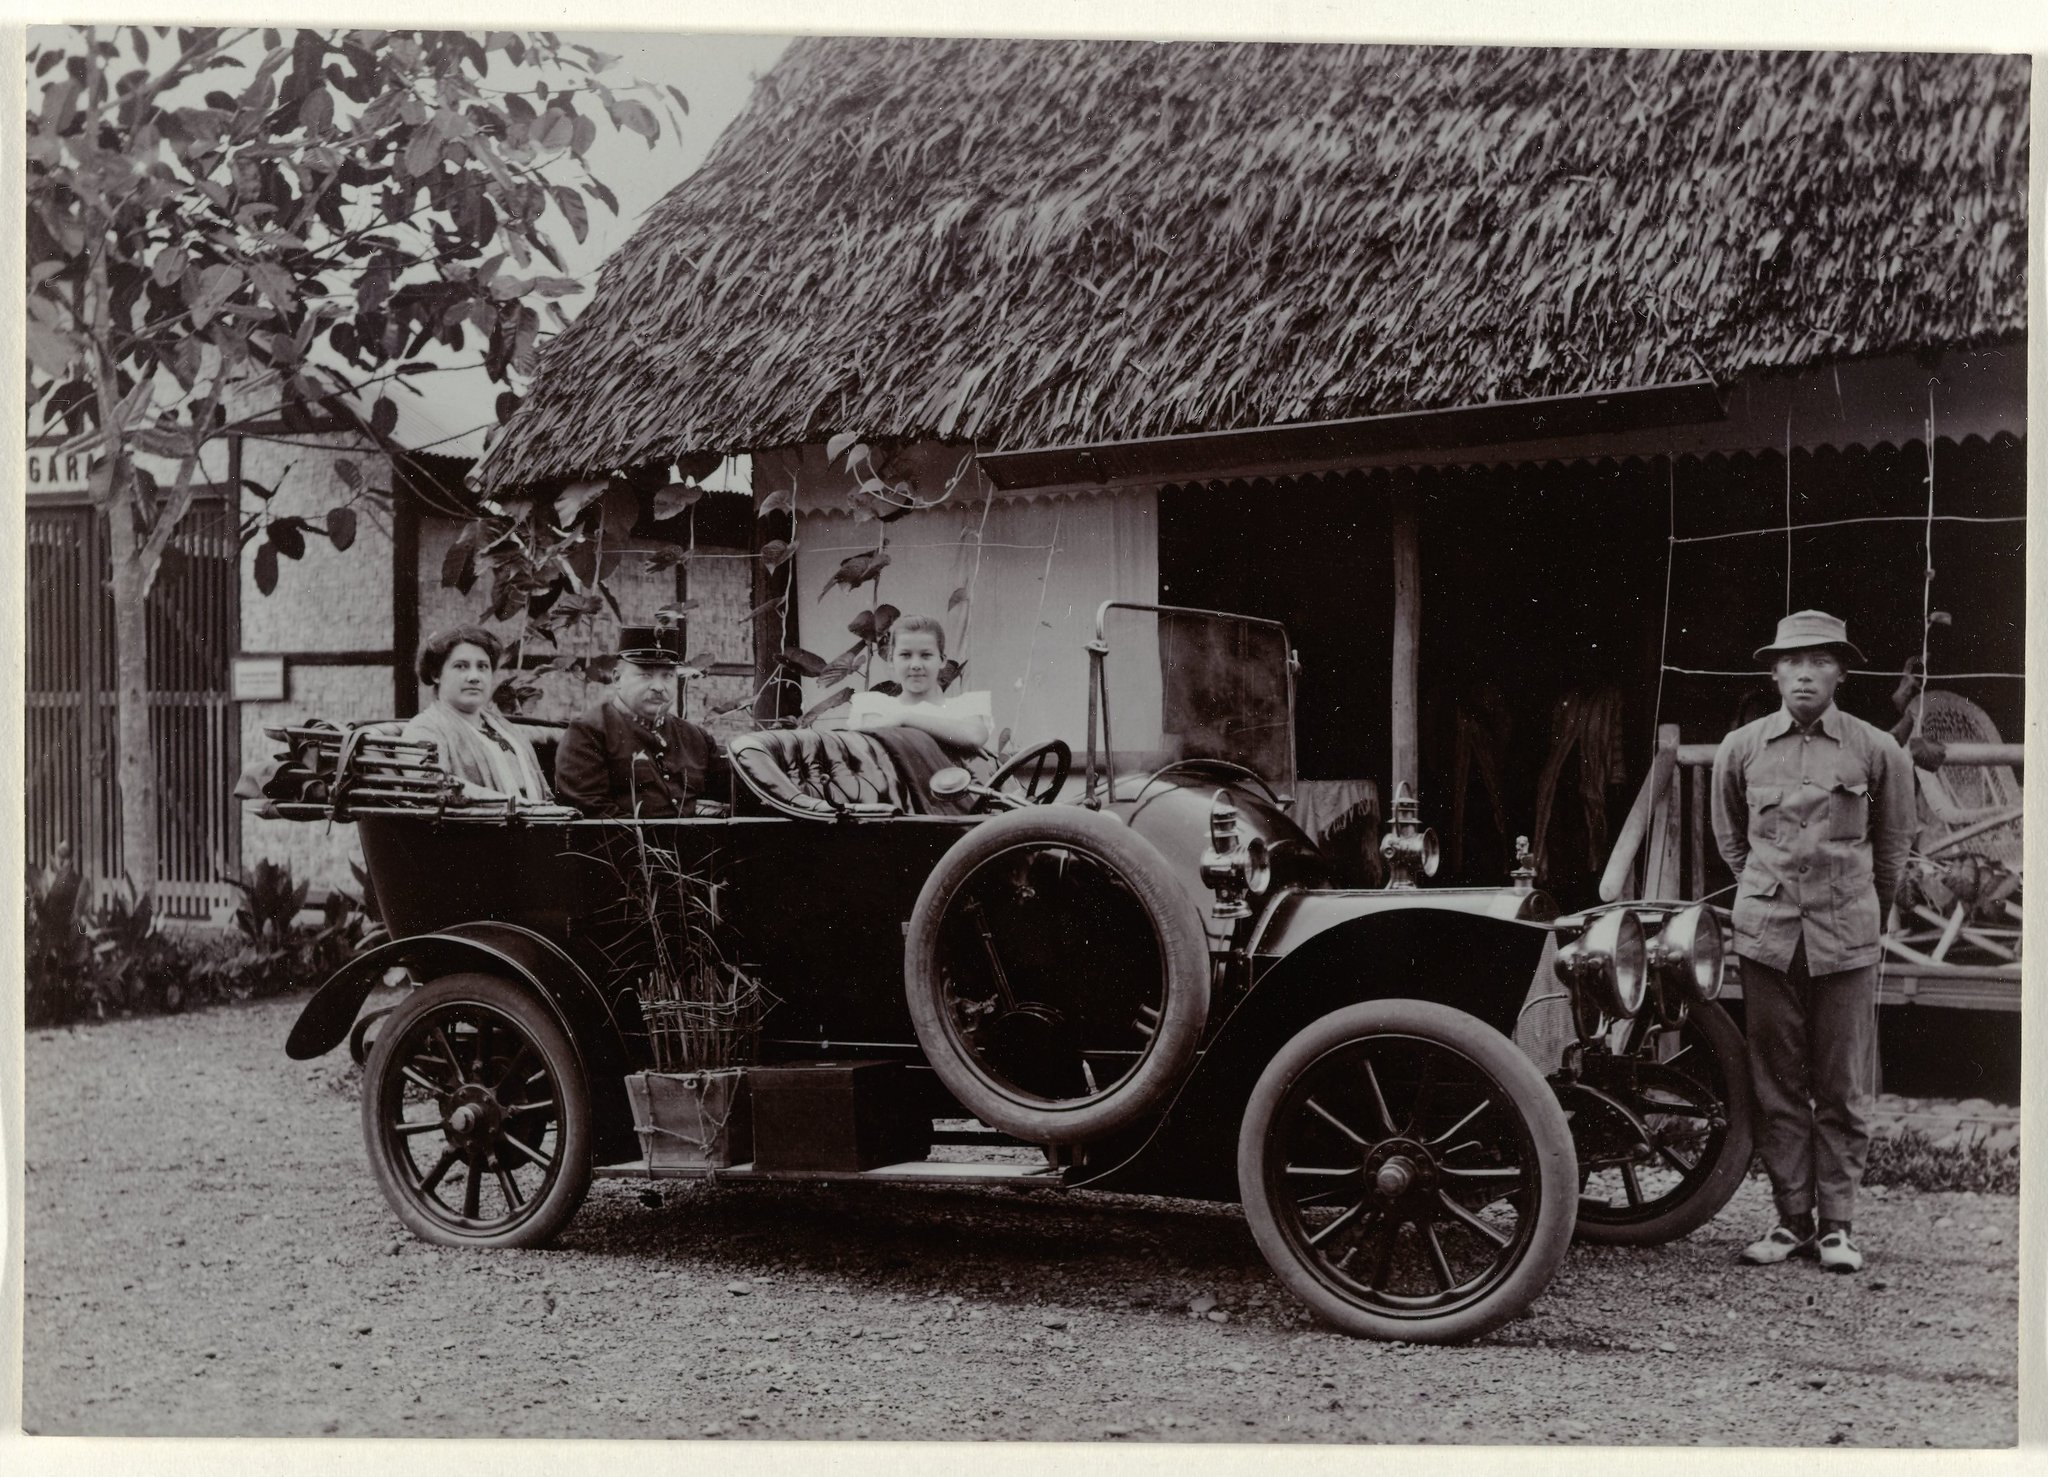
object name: photograph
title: Officier met vrouw en kind en chauffeur bij een auto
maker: Anonymous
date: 1903-1913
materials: photographic support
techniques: photography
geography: north sumatra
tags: family group, especially parents with their child(ren), automobile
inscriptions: inscription: ‘55’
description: Na de expedities naar de Gajo- en Alaslanden o.l.v. Van Daalen (eerste tocht in 1901), werd hij in 1903 belast met voorbereiding van permanente vestiging van Nederlands gezag. Aanleg van een weg van de Noordkust naar het binnenland was hierbij van groot belang. Deze zgn. Gajoweg werd aangelegd tussen 1903 en 1914, van Bireuen aan de kust naar Takinguen aan het bergmeer Danau Lauttawar, totale lengte 104 km.